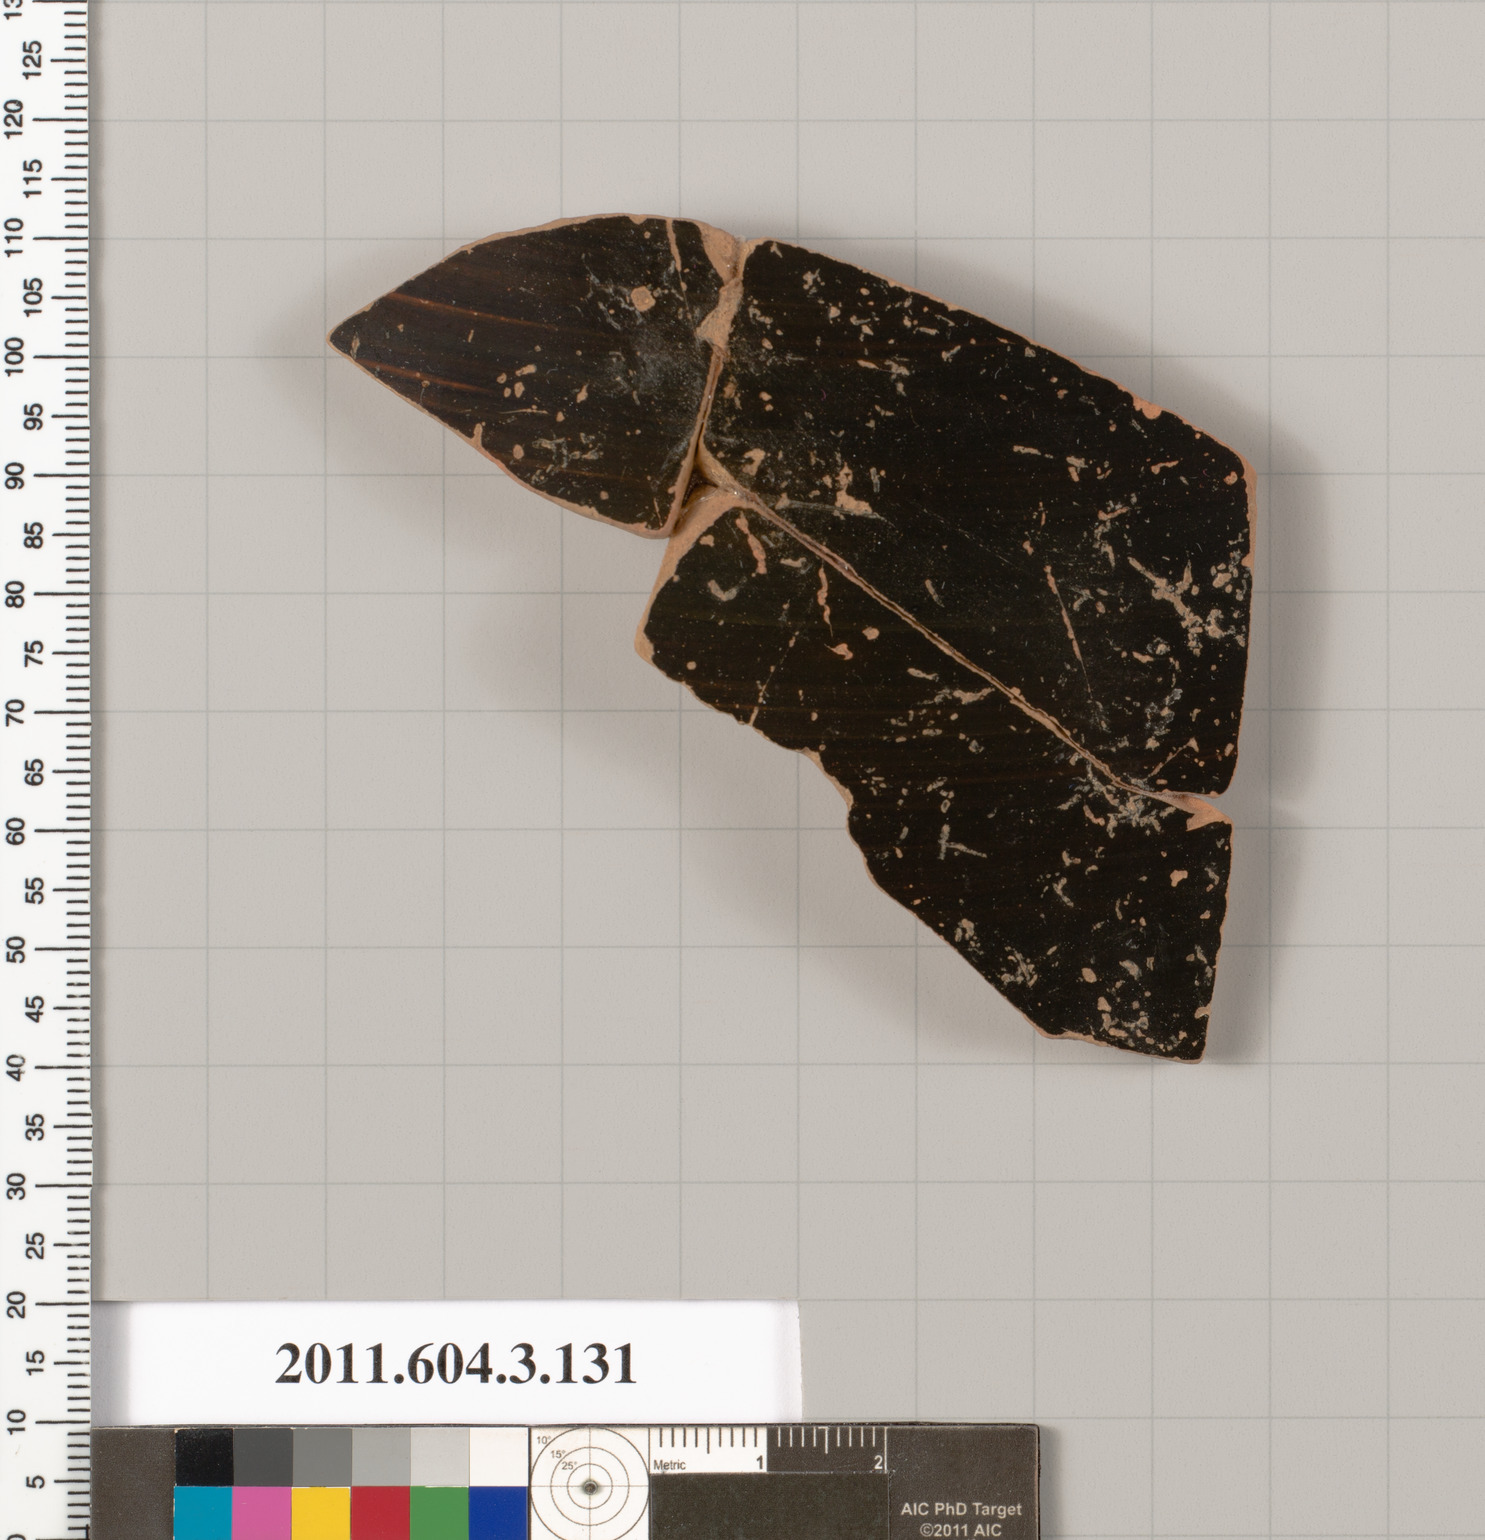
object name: amphora fragment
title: Terracotta fragment of an amphora (jar)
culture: greek, attic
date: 600-468 BCE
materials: terracotta